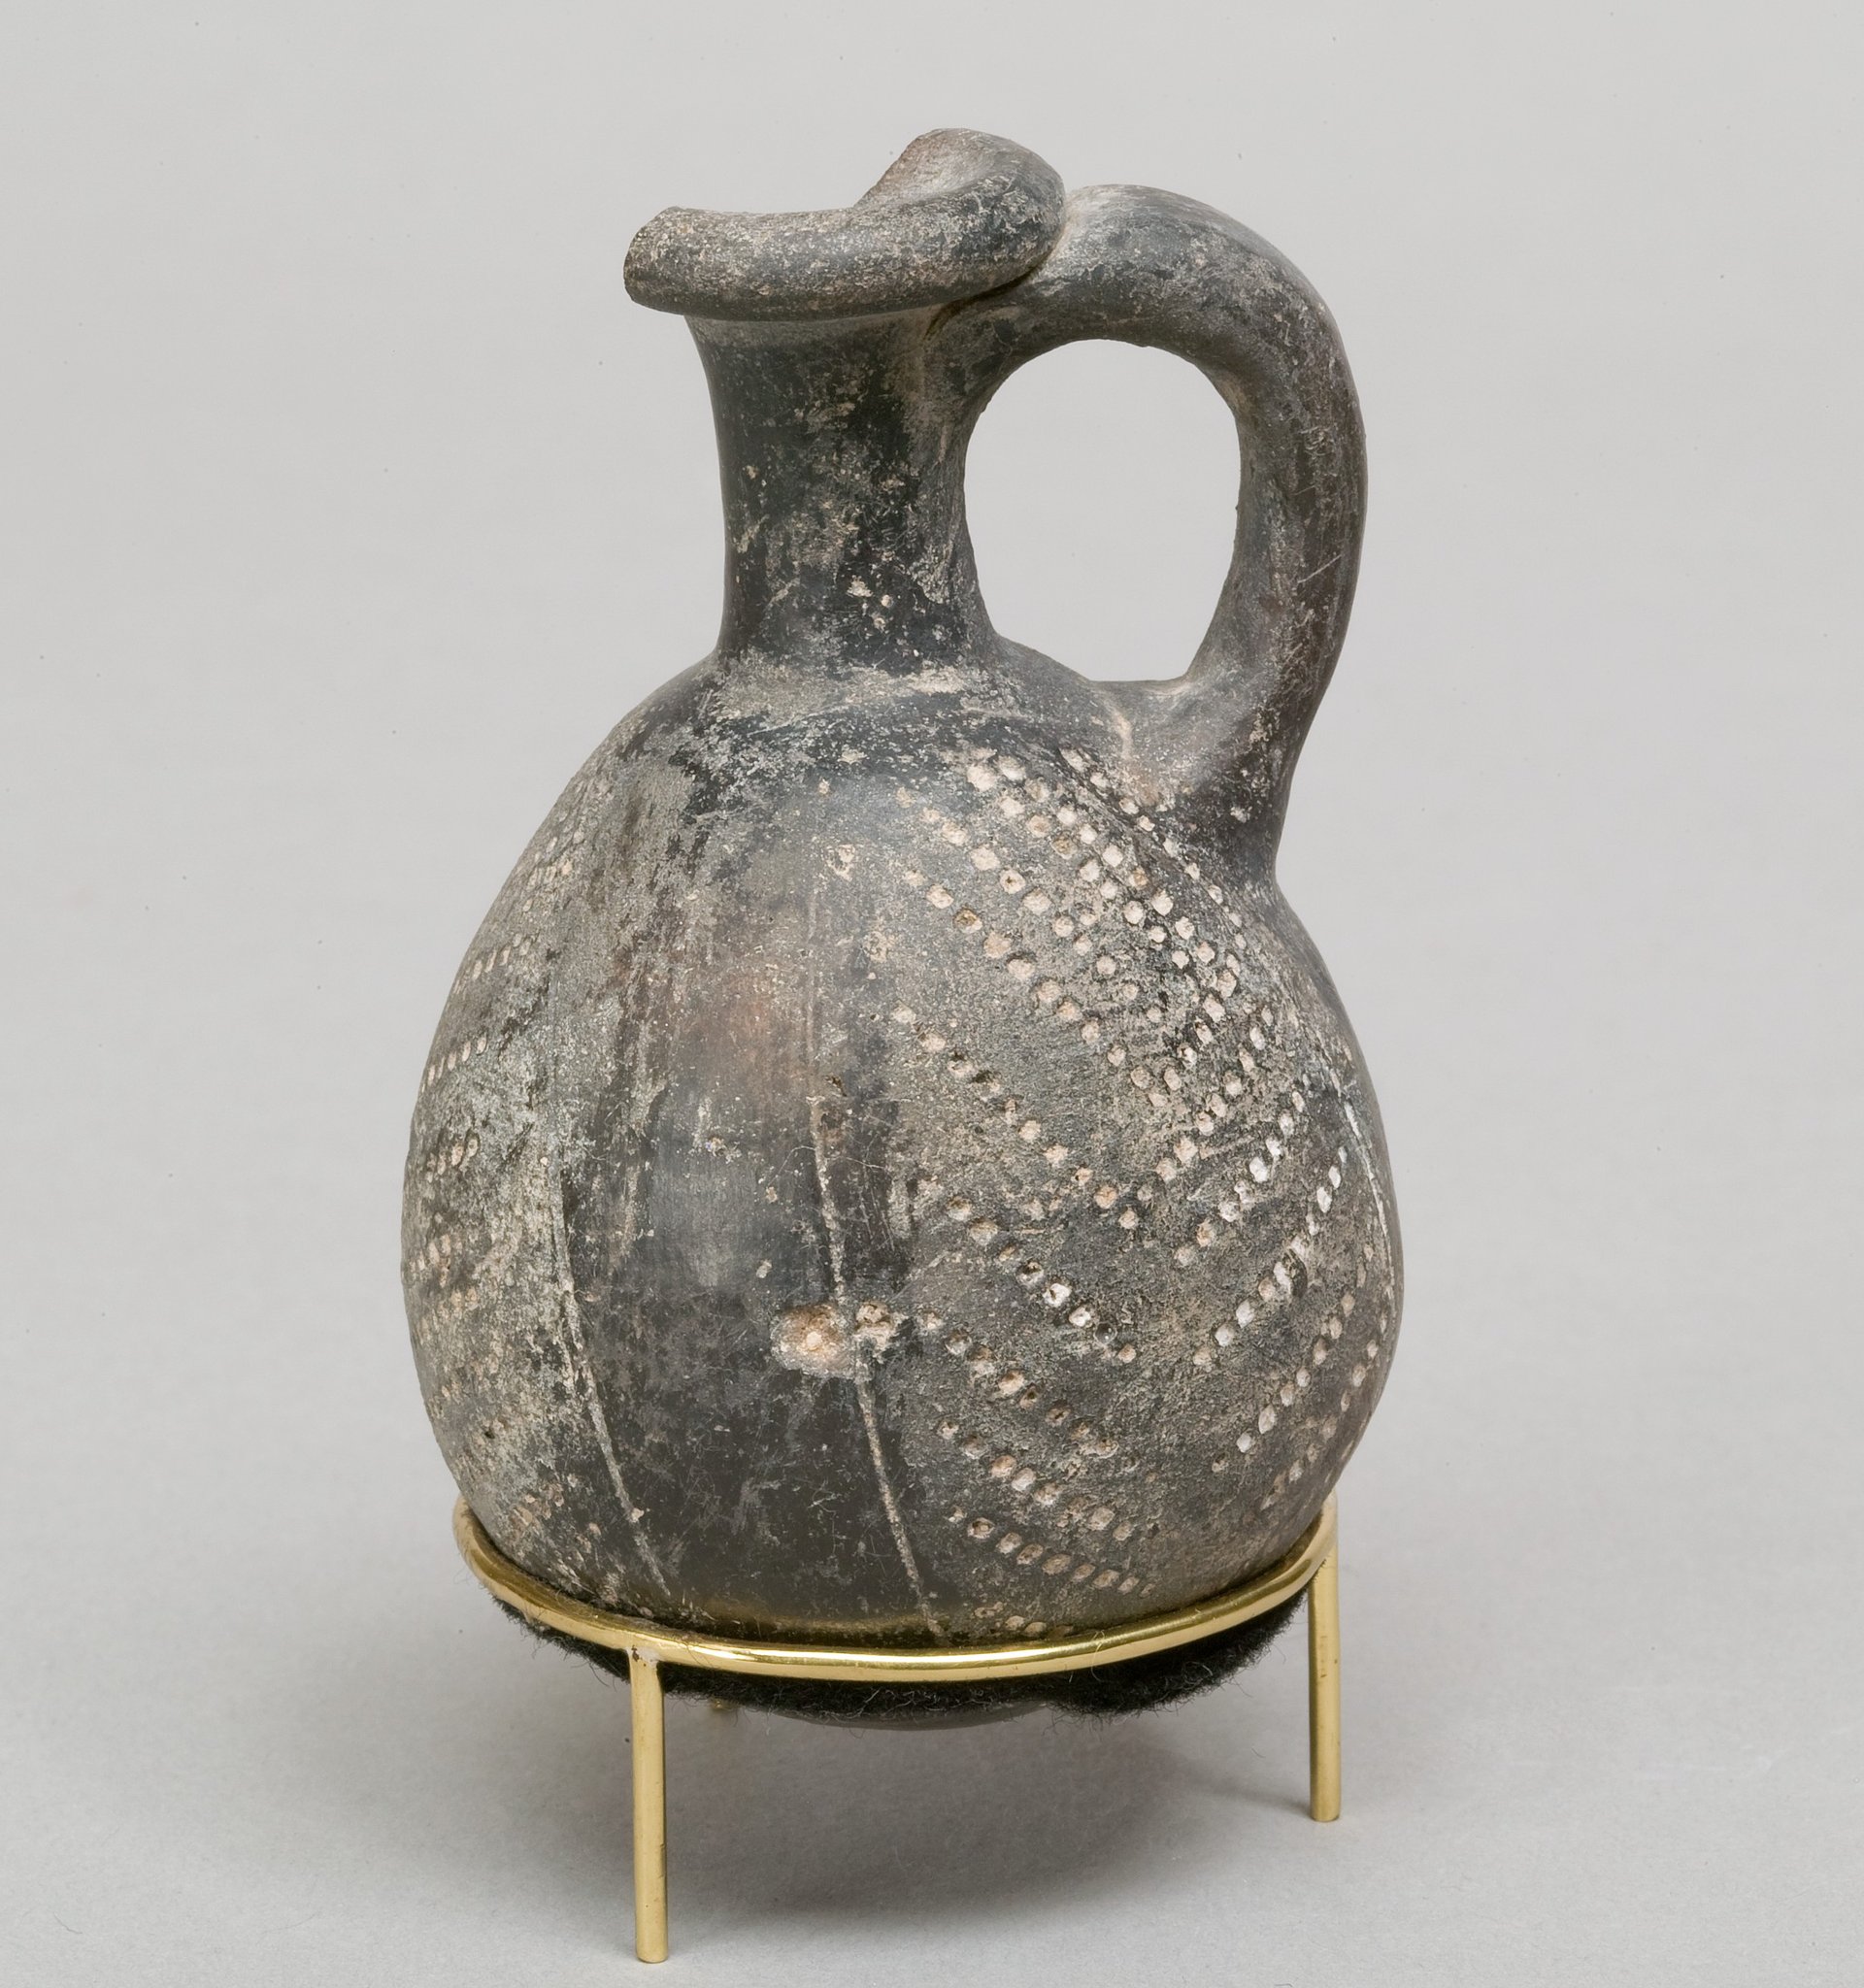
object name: juglet, tell el yahudiya ware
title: Tell el-Yahudiya-ware juglet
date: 1750-1700 BCE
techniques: incising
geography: egypt